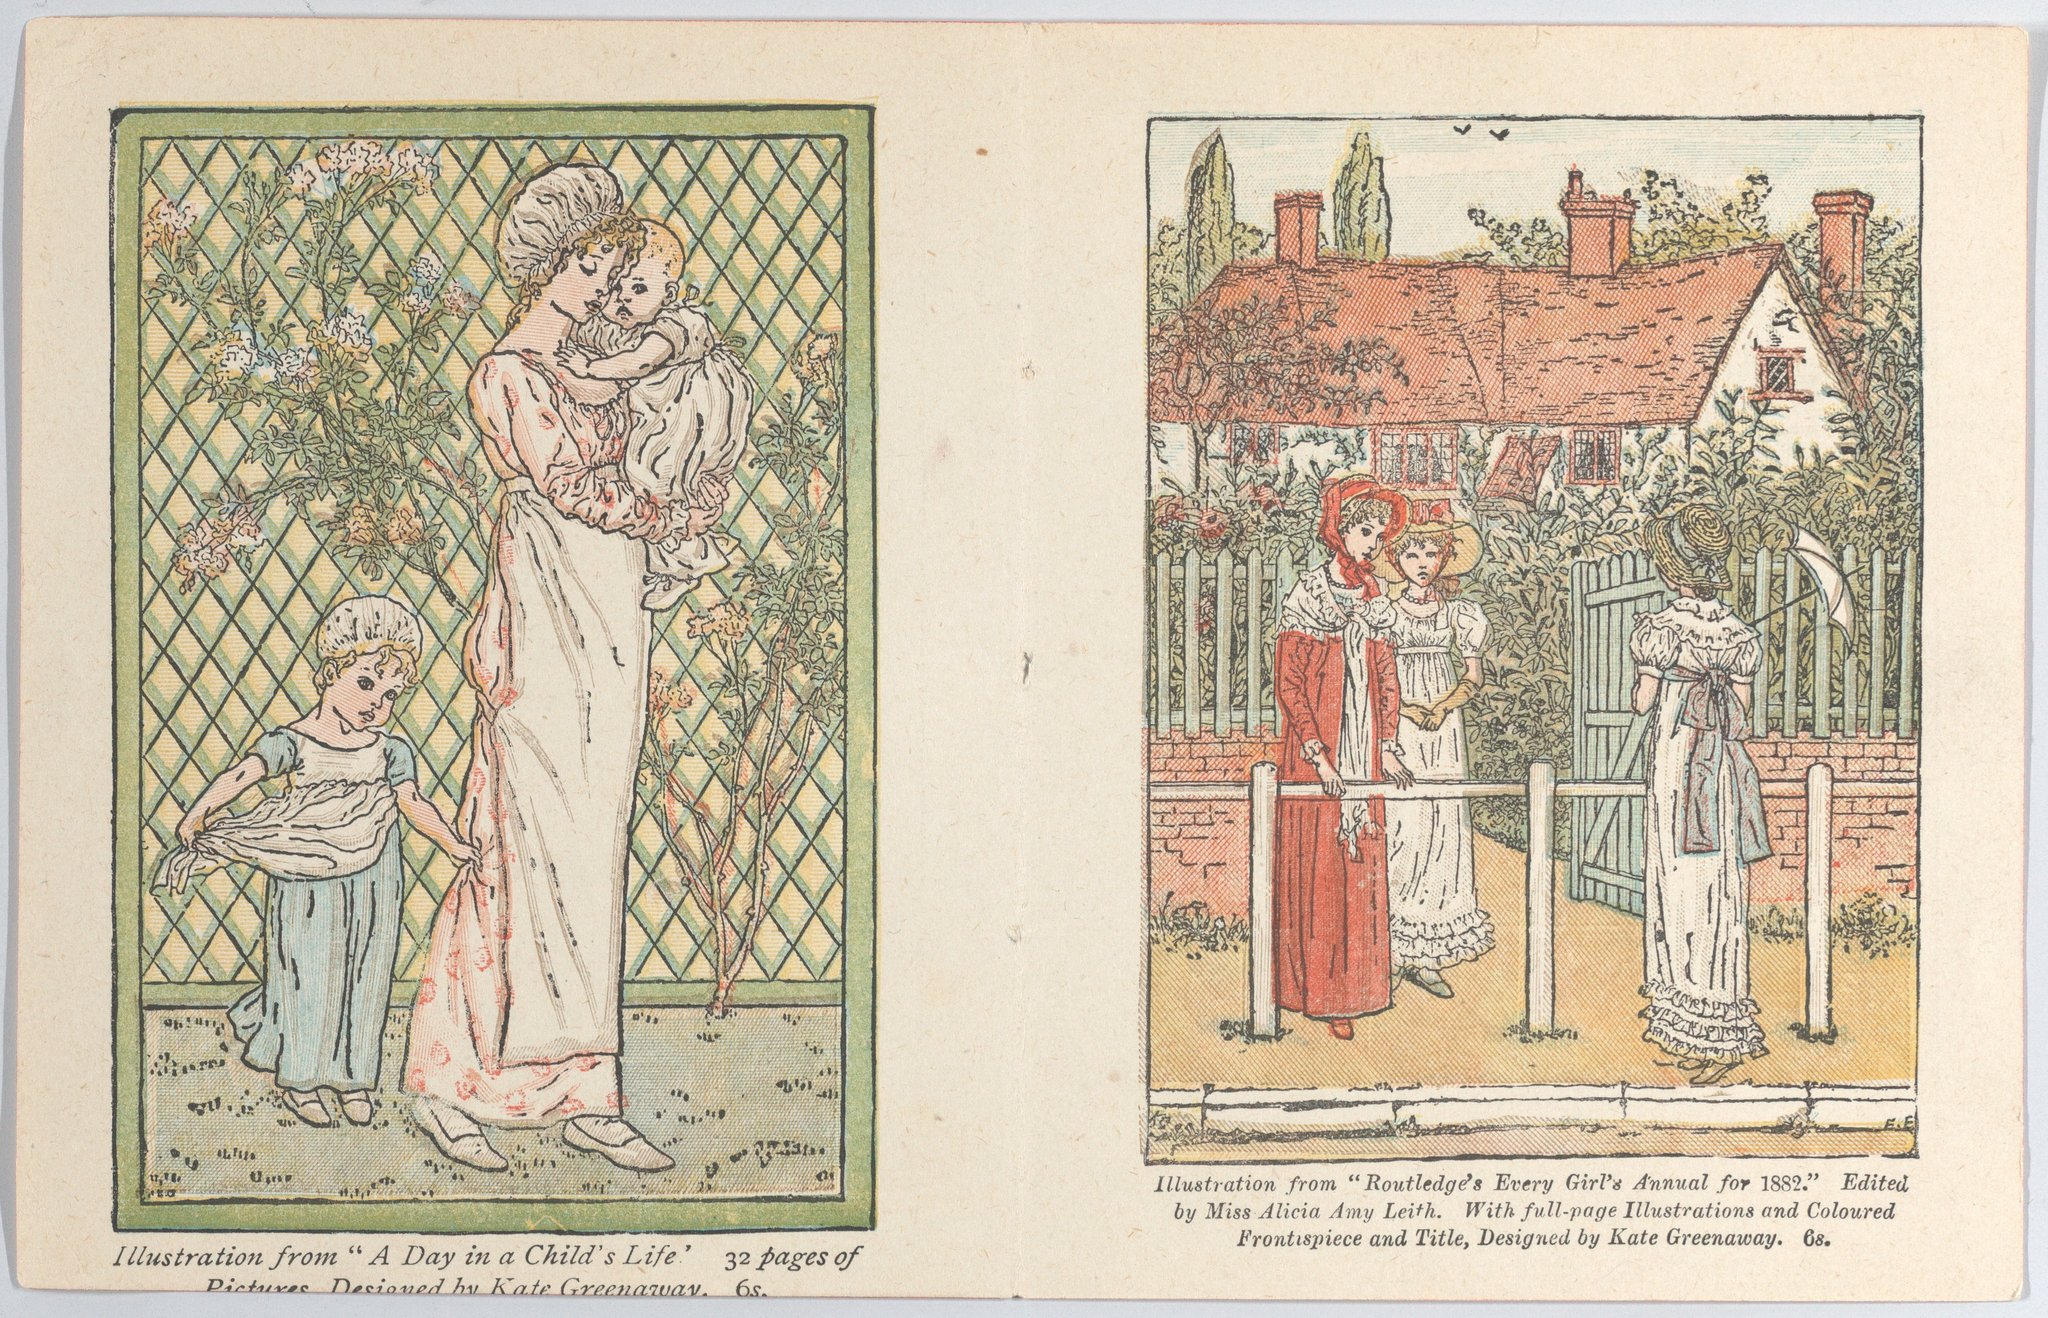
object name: valentine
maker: kate greenaway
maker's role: artist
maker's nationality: british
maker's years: 1846-1901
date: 1882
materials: paper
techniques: chromolithography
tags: children,infants,women